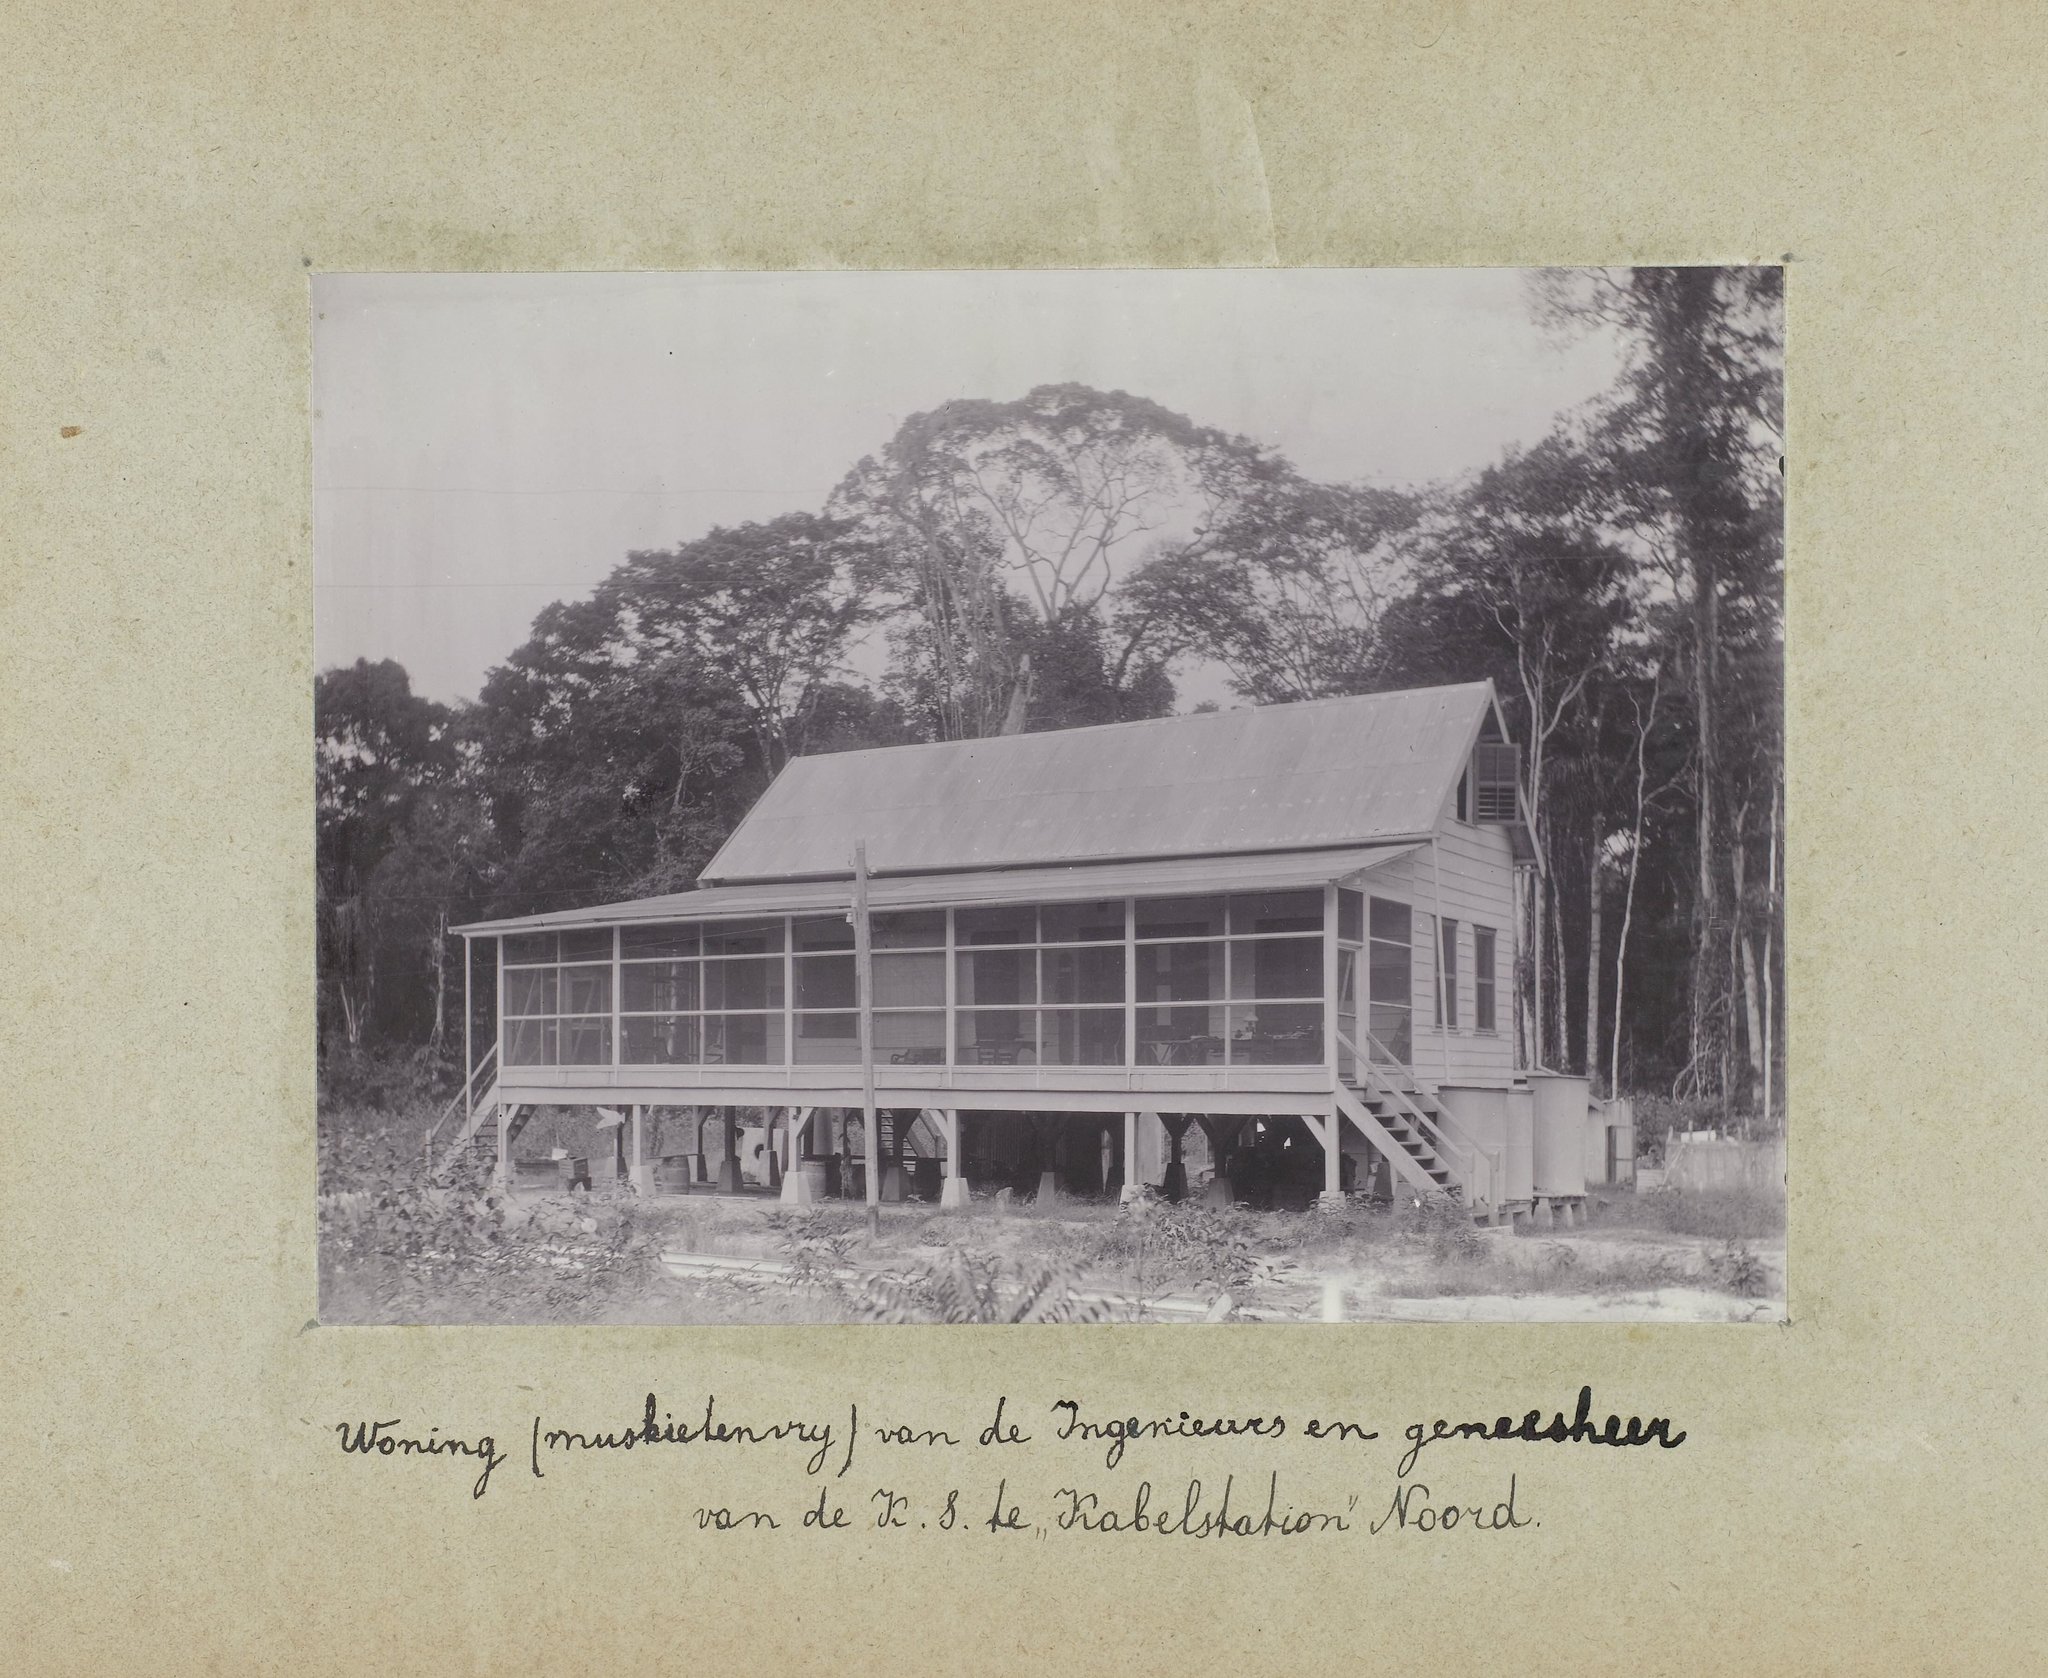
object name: photograph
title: Woning (muskietenvrij) van de Ingenieurs en geneesheer van de K.S. te "Kabelstation" Noord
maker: Anonymous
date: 1905-1910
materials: photographic support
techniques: photography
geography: suriname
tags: jacob evert wesenhagen, railway, tramway; rack railway, suriname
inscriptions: inscription: ‘Woning (muskietenvrij) van de Ingenieurs en geneesheer van de K.S. te "Kabelstation" Noord’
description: De woning van de ingenieurs en de kampgeneesheer (J.E. Wesenhagen) bij het kabelstation aan de noordzijde. Foto in het fotoalbum over de aanleg van de Lawaspoorweg in Suriname in de jaren 1903-1912. Onderdeel van een groep objecten afkomstig van de familie Wesenhagen in Suriname.